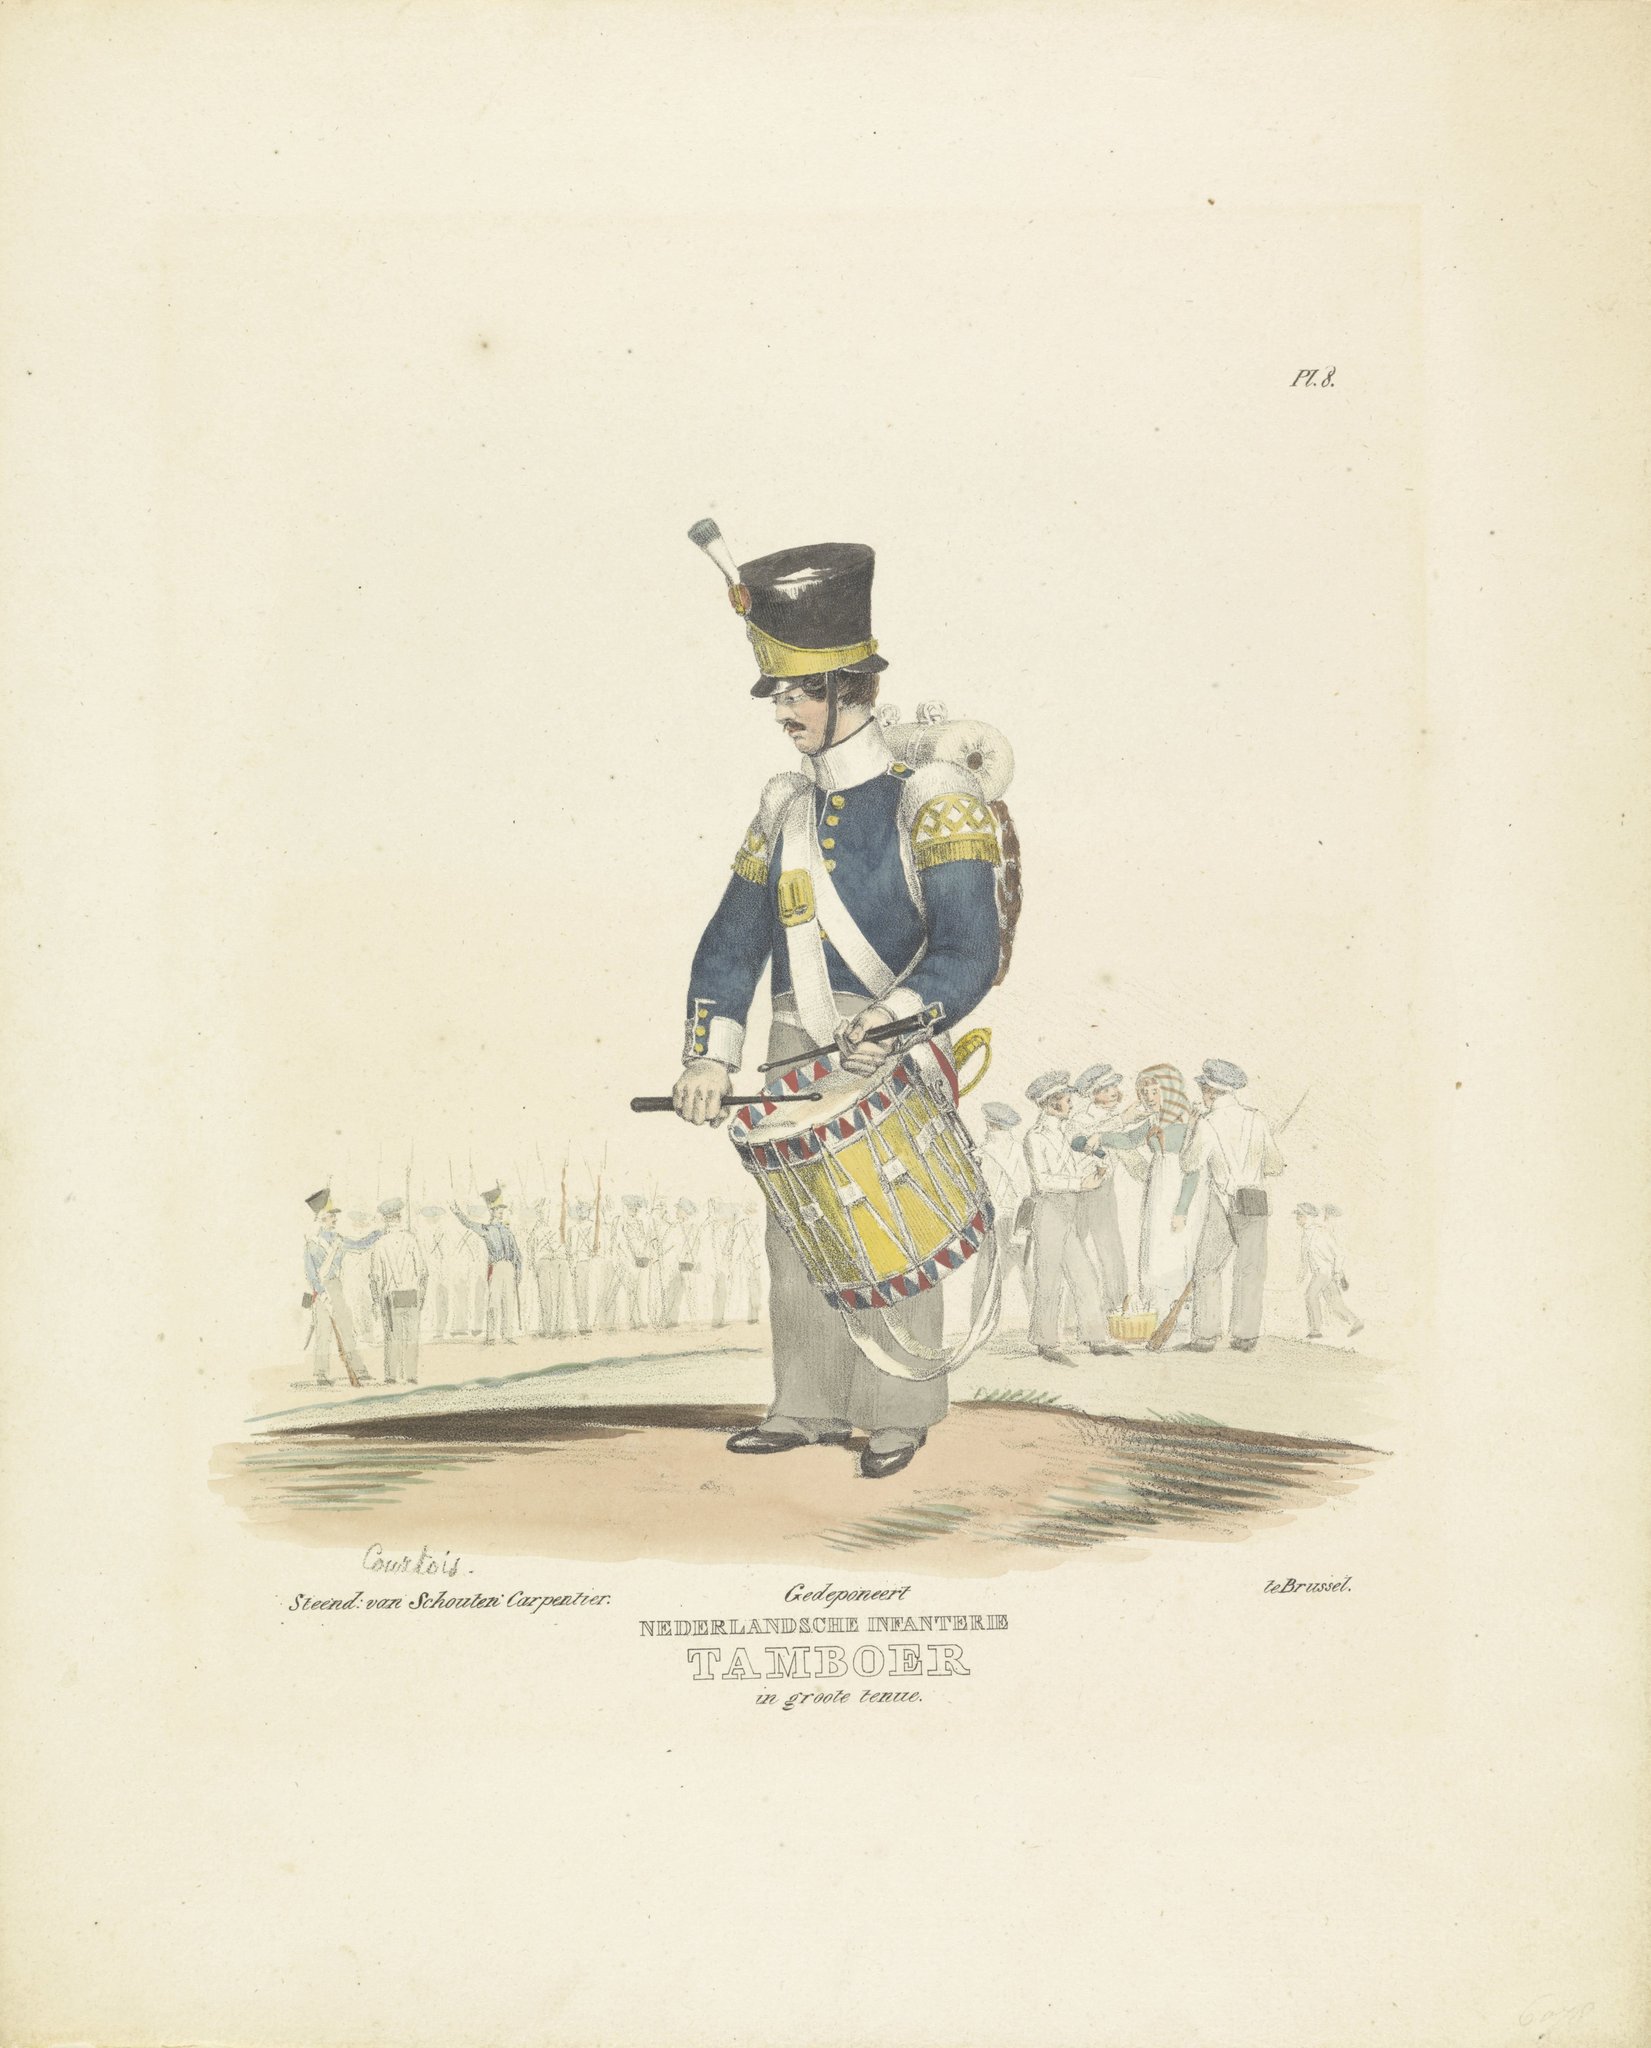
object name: costume print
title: Drummer in Full Uniform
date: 1825-1827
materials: paper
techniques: hand coloring, lithograph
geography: brussels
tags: military music, (military) uniforms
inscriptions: collector's mark: Lugt 2228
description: Uniformvoorstelling van een staande tamboer van de infanterie in grote tenue. Genummerd rechtsboven: Pl. 8. Onderdeel van de reeks van 53 platen van uniformen van de militairen van het Koninkrijk der Nederlanden in de periode 1820-1825.